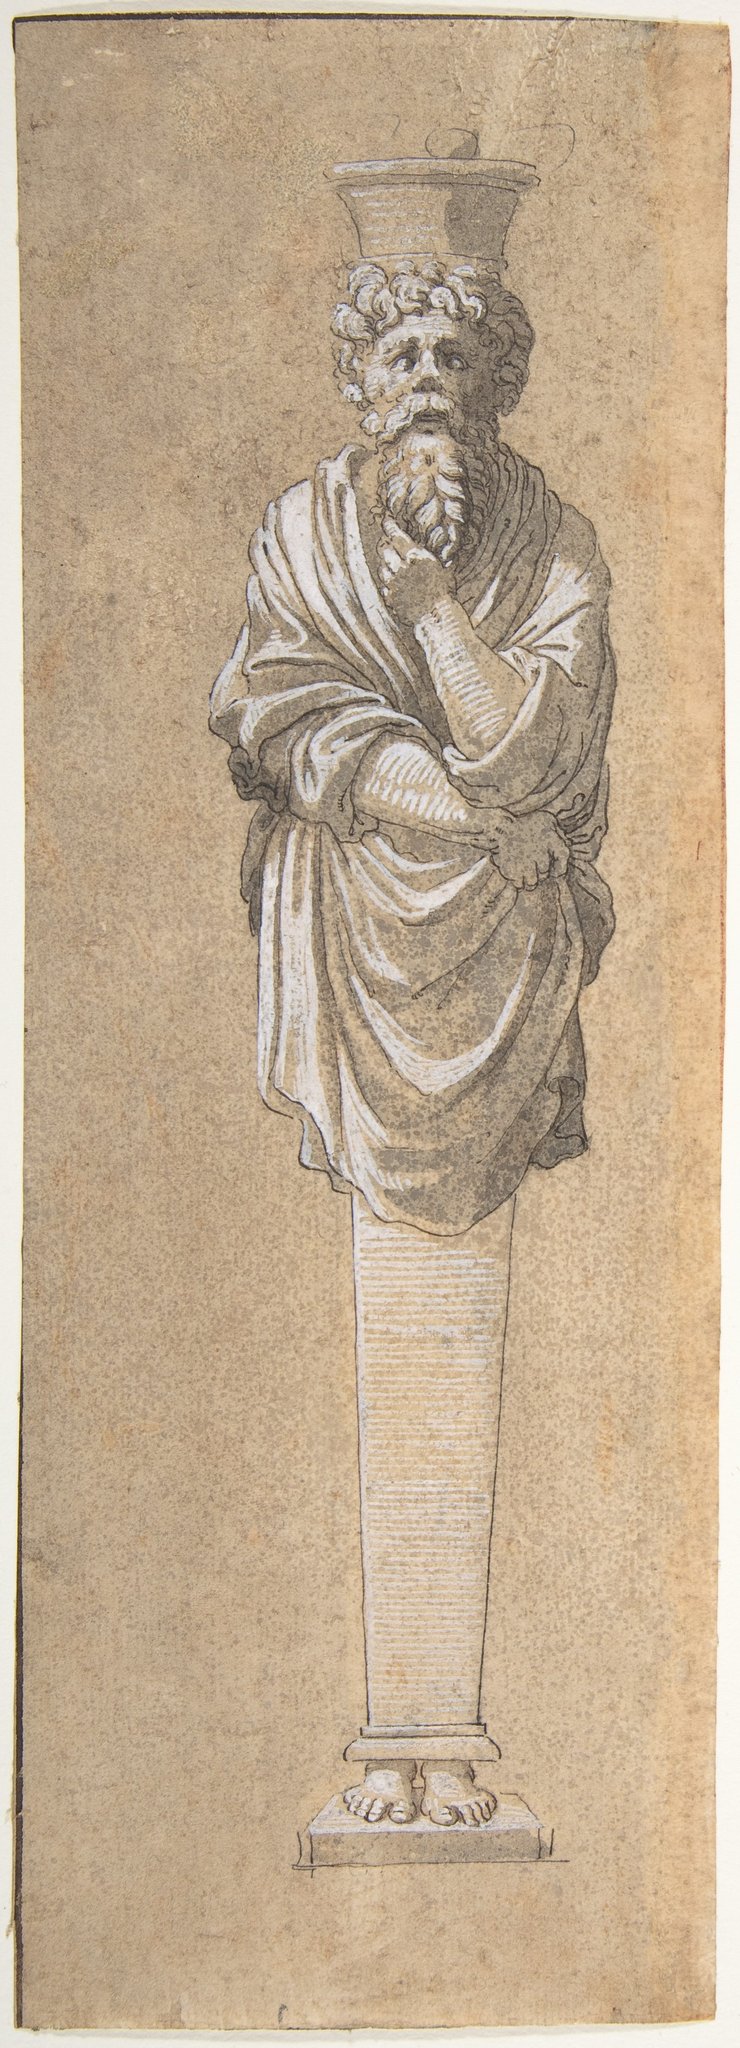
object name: drawing ornament architecture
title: Bearded Male Term Covered in a Cloak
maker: anonymous, french, 16th century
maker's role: artist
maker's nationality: french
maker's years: 1500-1600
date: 1545-1565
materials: ink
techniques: heightening, pen, wash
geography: italy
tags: men